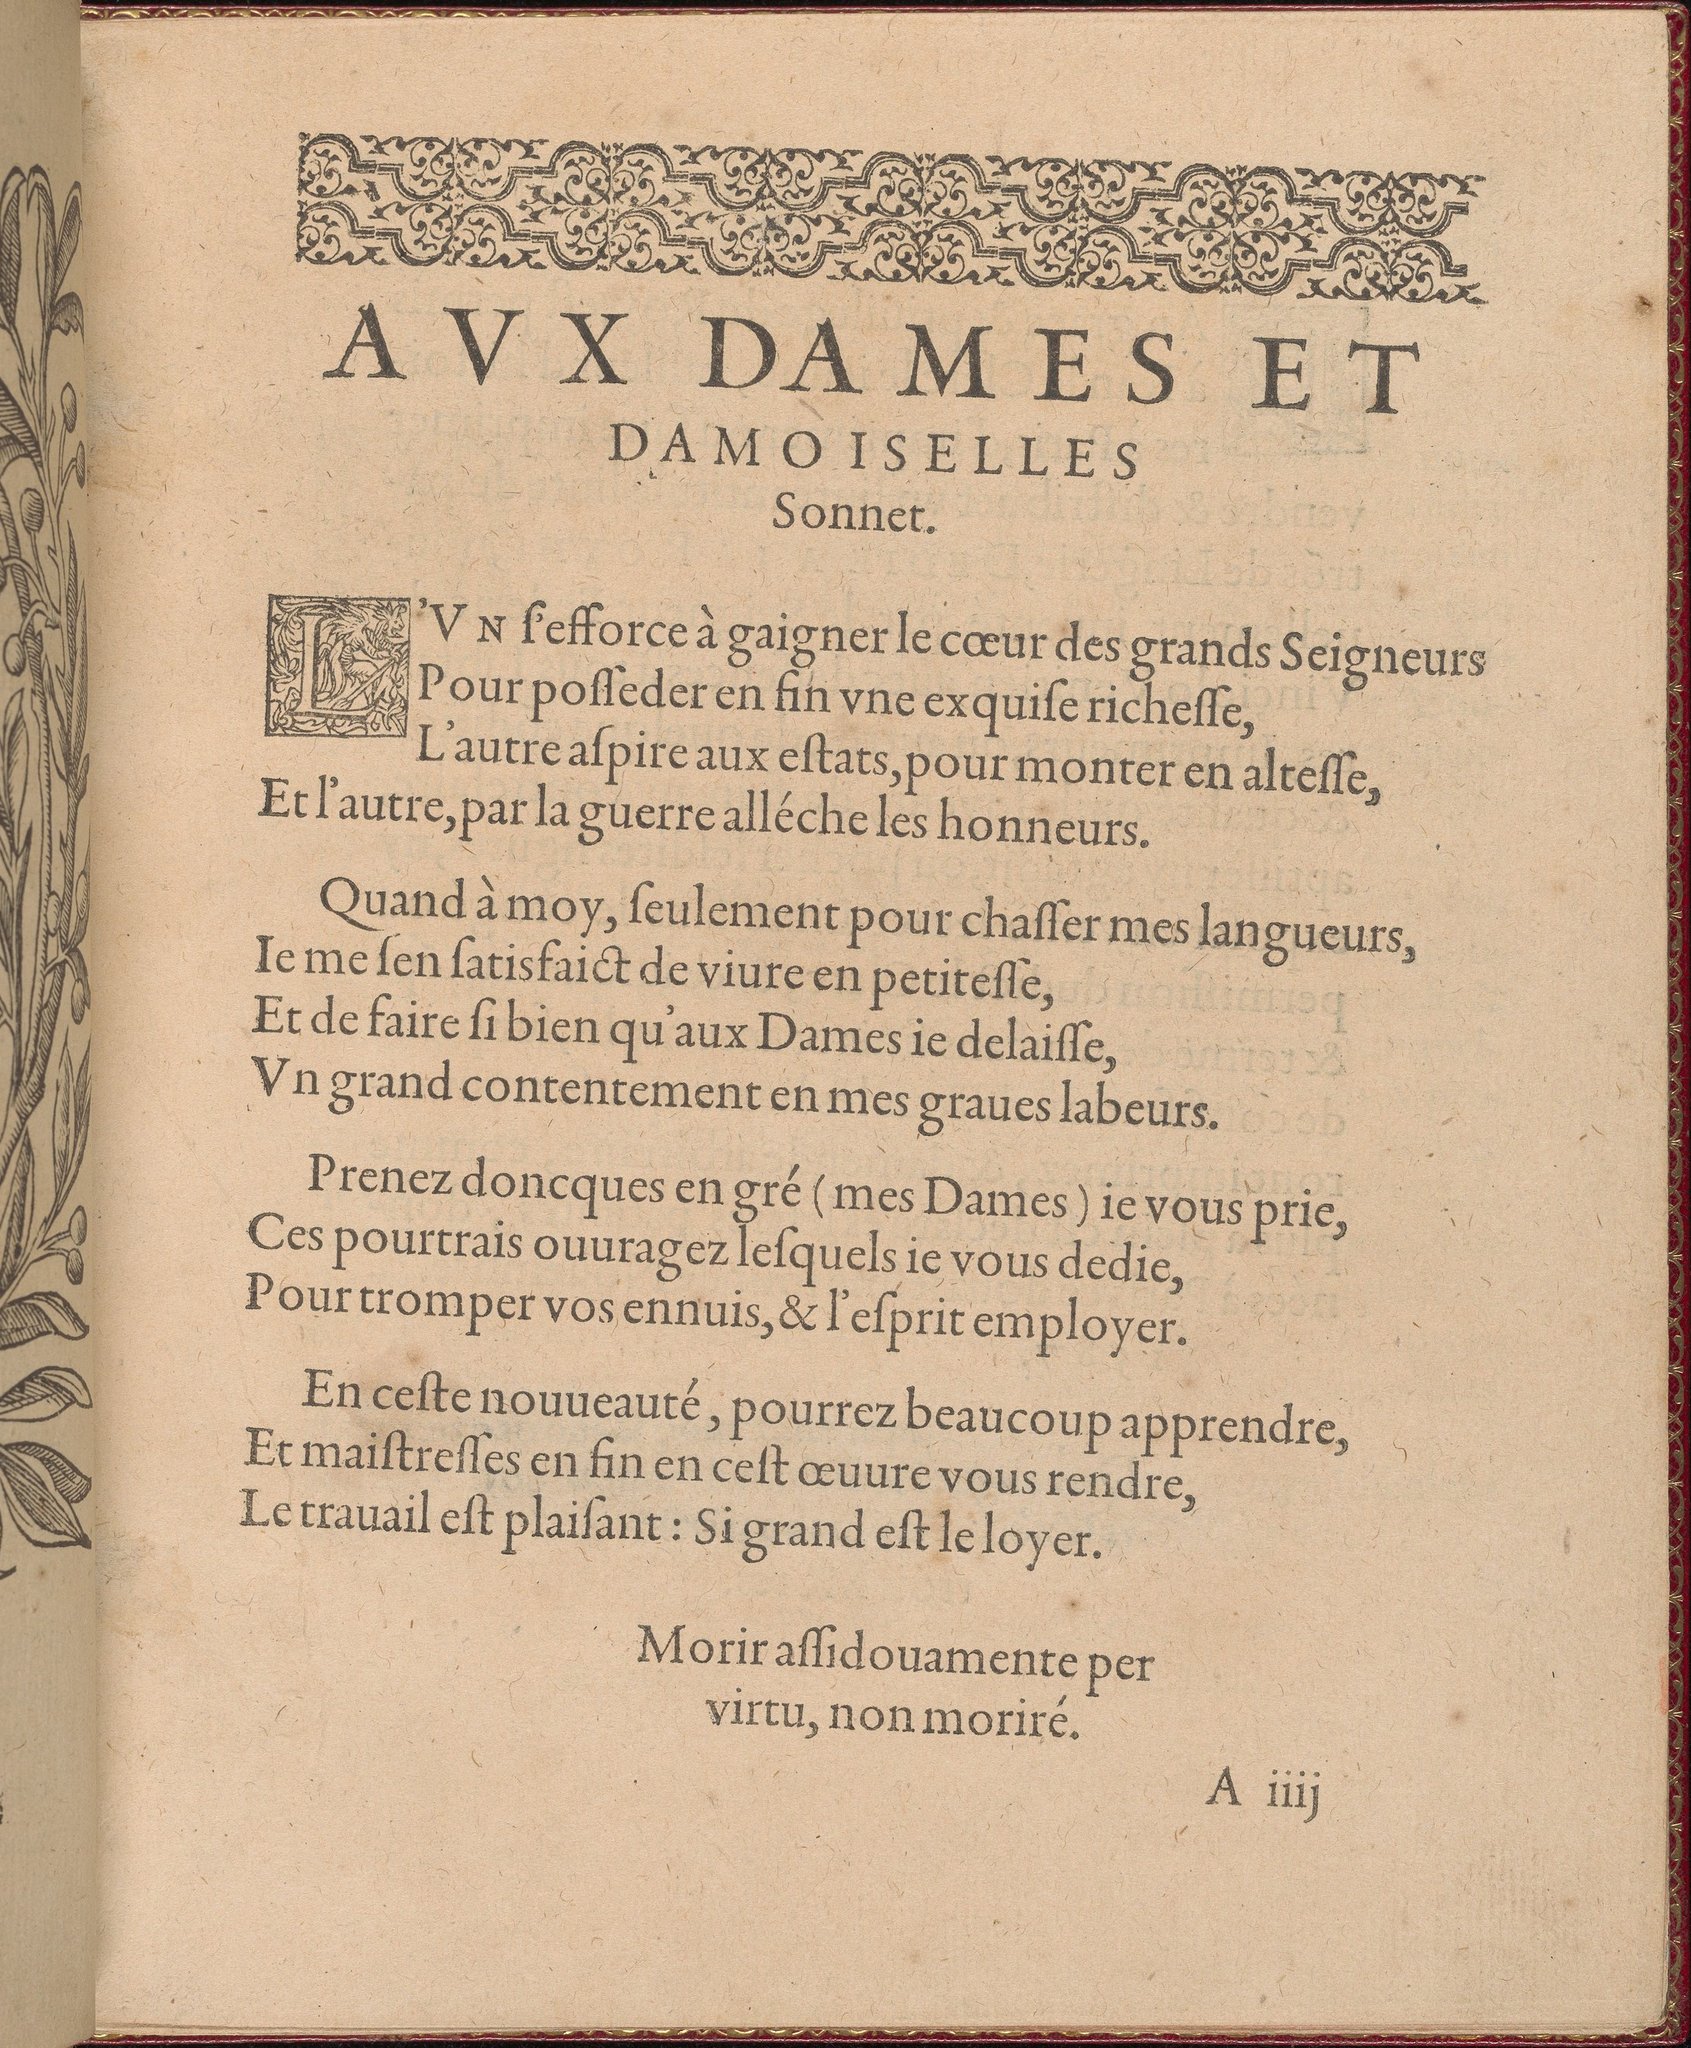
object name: book print ornament architecture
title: Les Singuliers et Nouveaux Portraicts... page 3 (recto)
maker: federico de vinciolo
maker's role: designer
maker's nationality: italian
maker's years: 1582-1599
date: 1588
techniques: woodcut